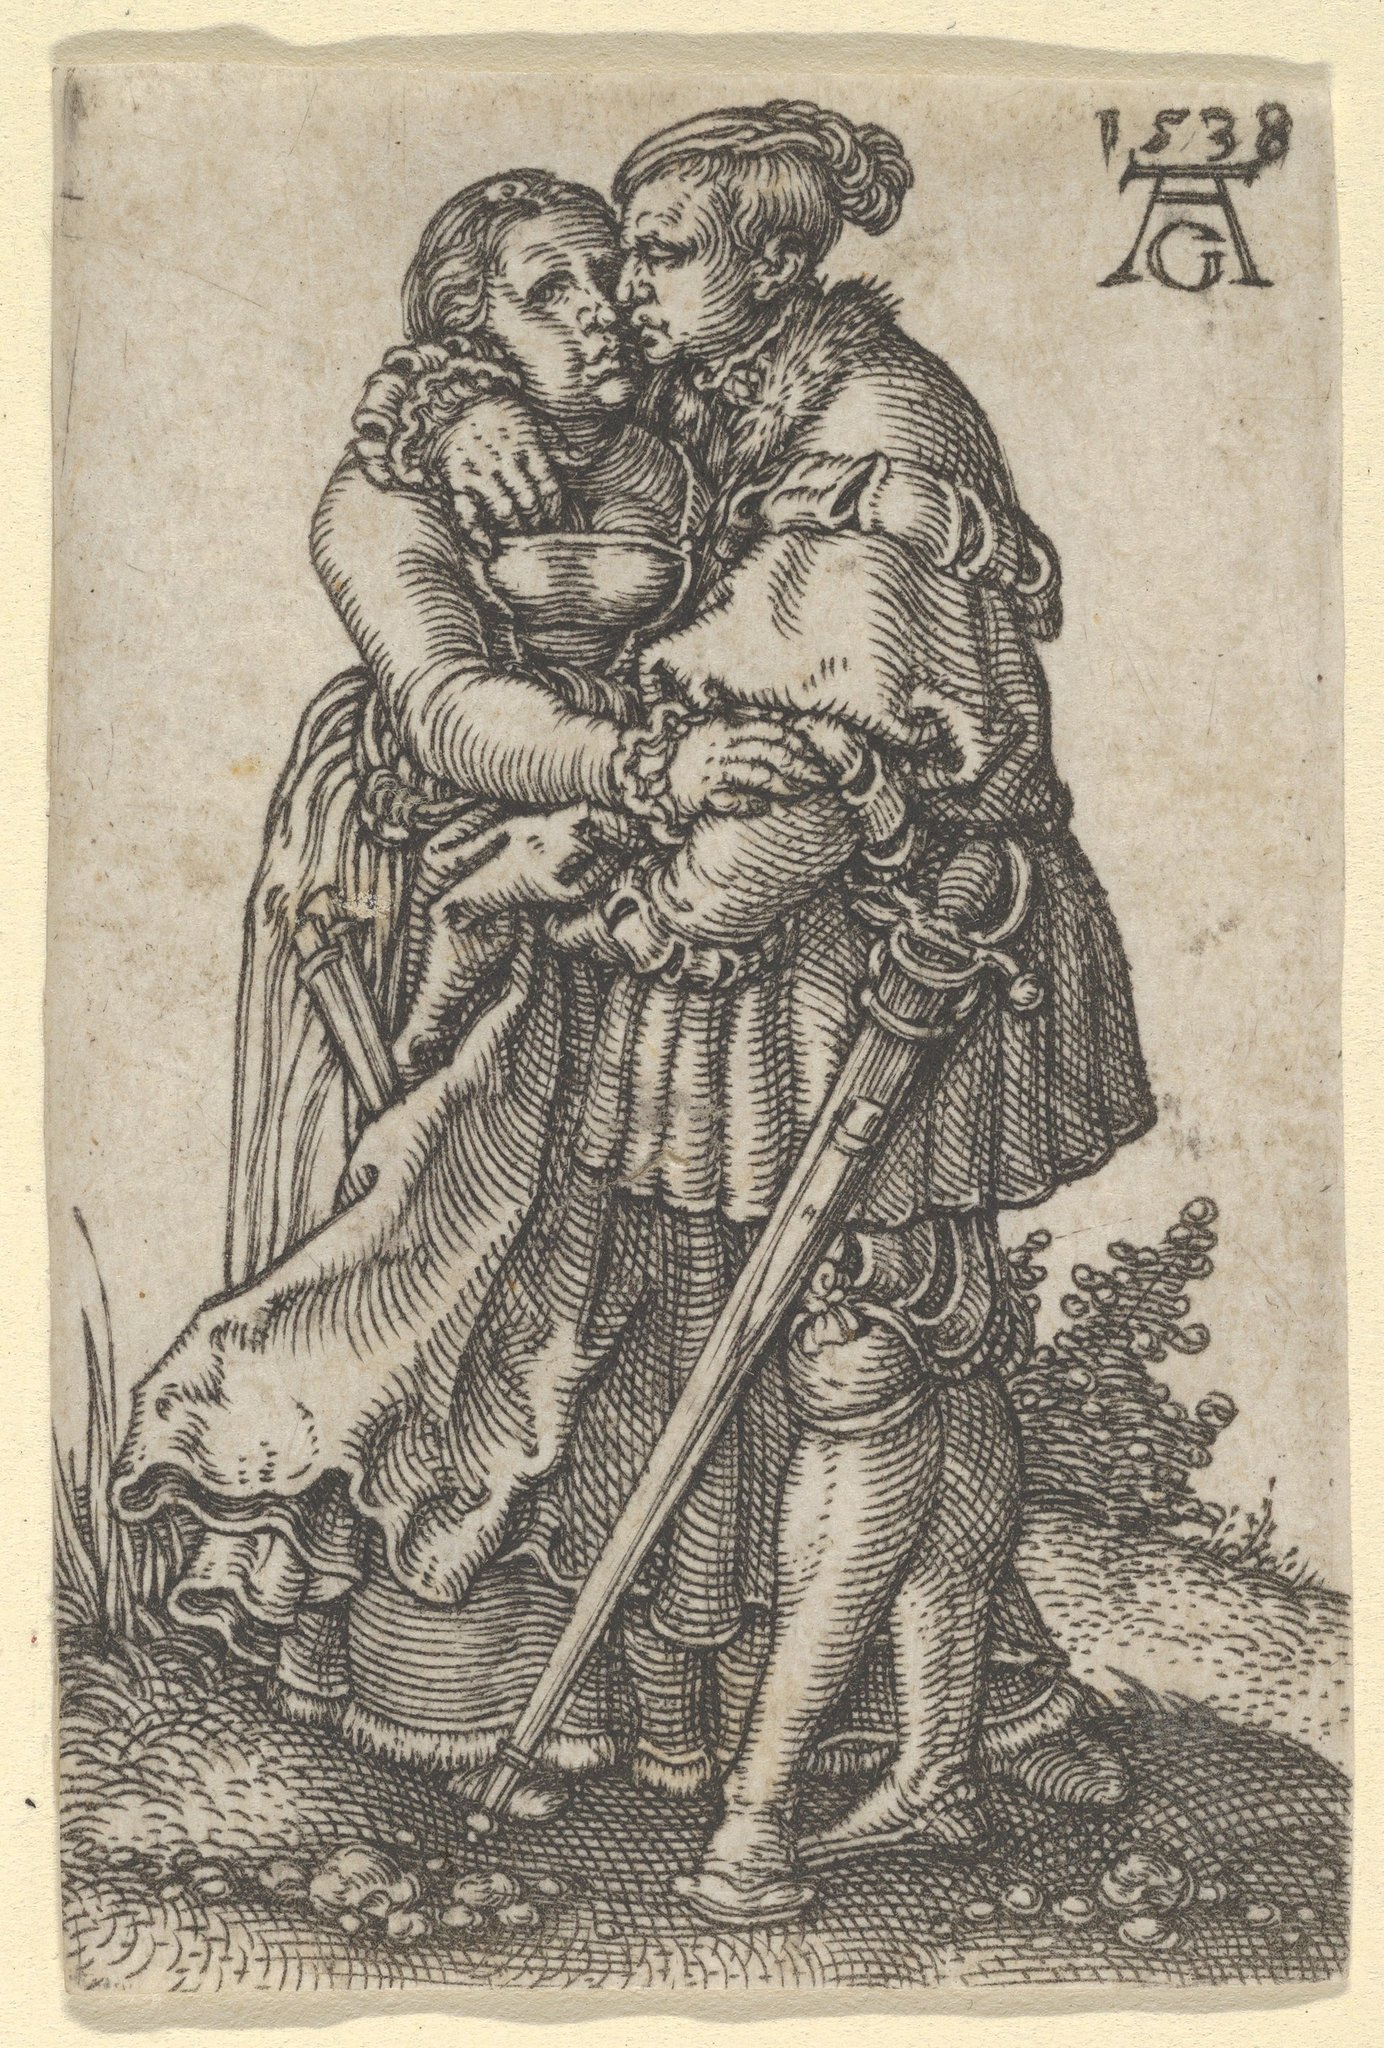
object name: print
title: Couple Embracing, from "The Small Wedding Dancers"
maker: heinrich aldegrever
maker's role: artist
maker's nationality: german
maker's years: 1502-1561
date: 1538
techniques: engraving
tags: couples,men,women,dancing